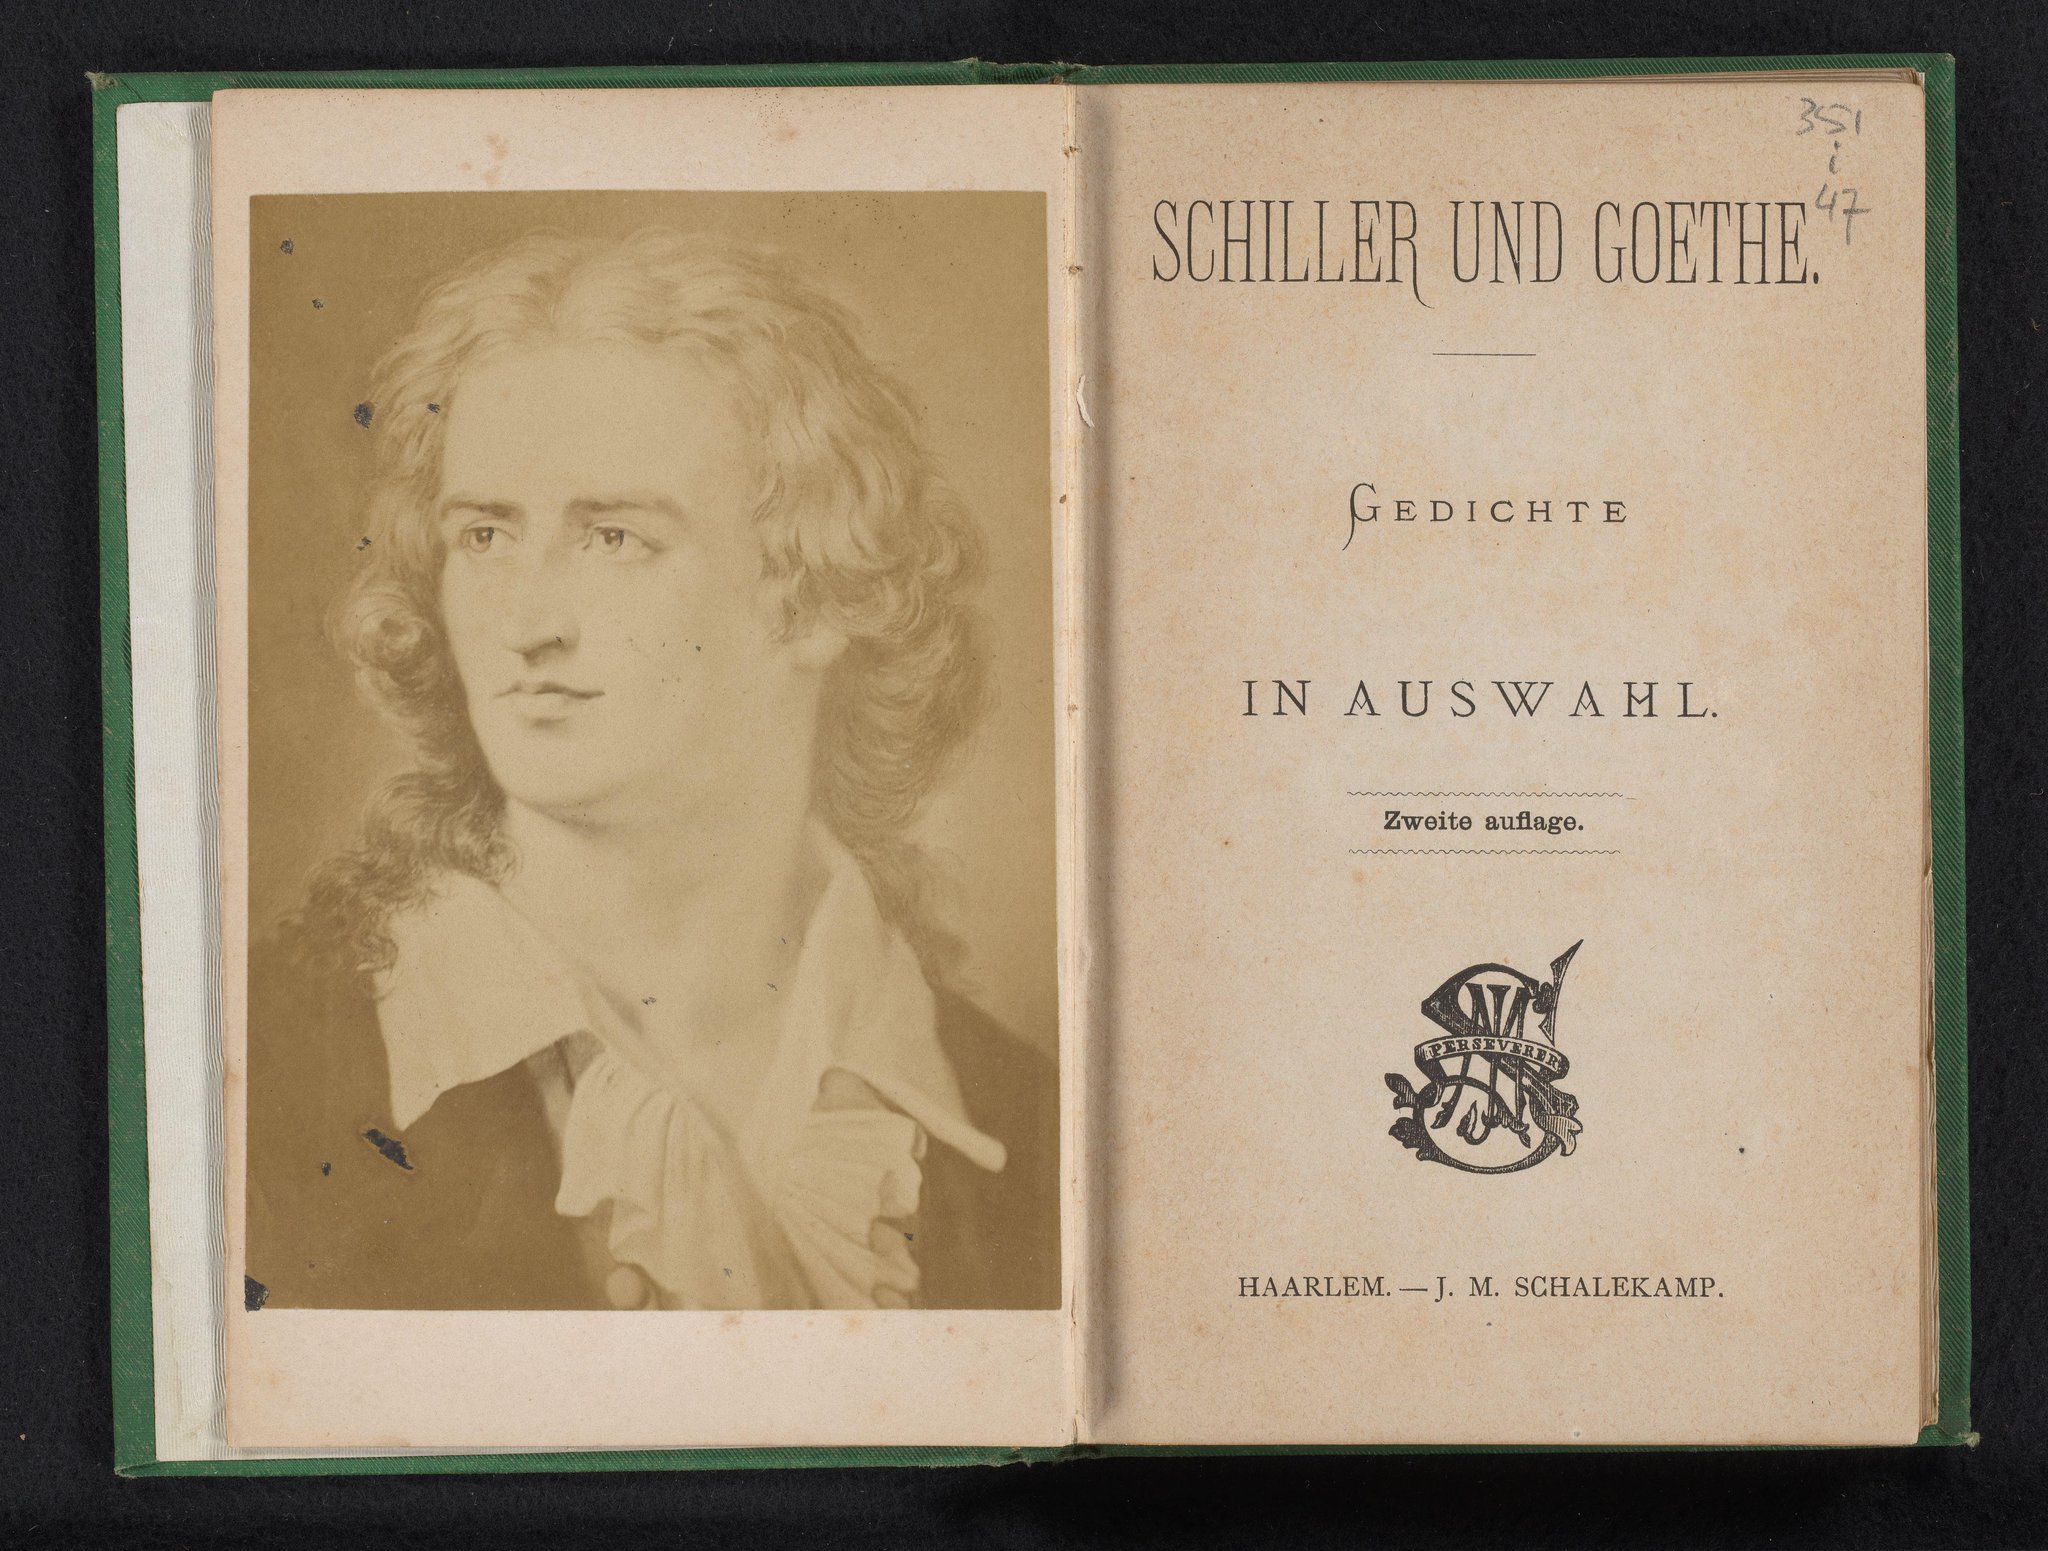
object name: reproduction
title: Fotoreproductie van een geschilderd portret van Friedrich von Schiller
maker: Anonymous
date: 1865-1875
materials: paper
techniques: albumen print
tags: friedrich von schiller, portrait of a writer